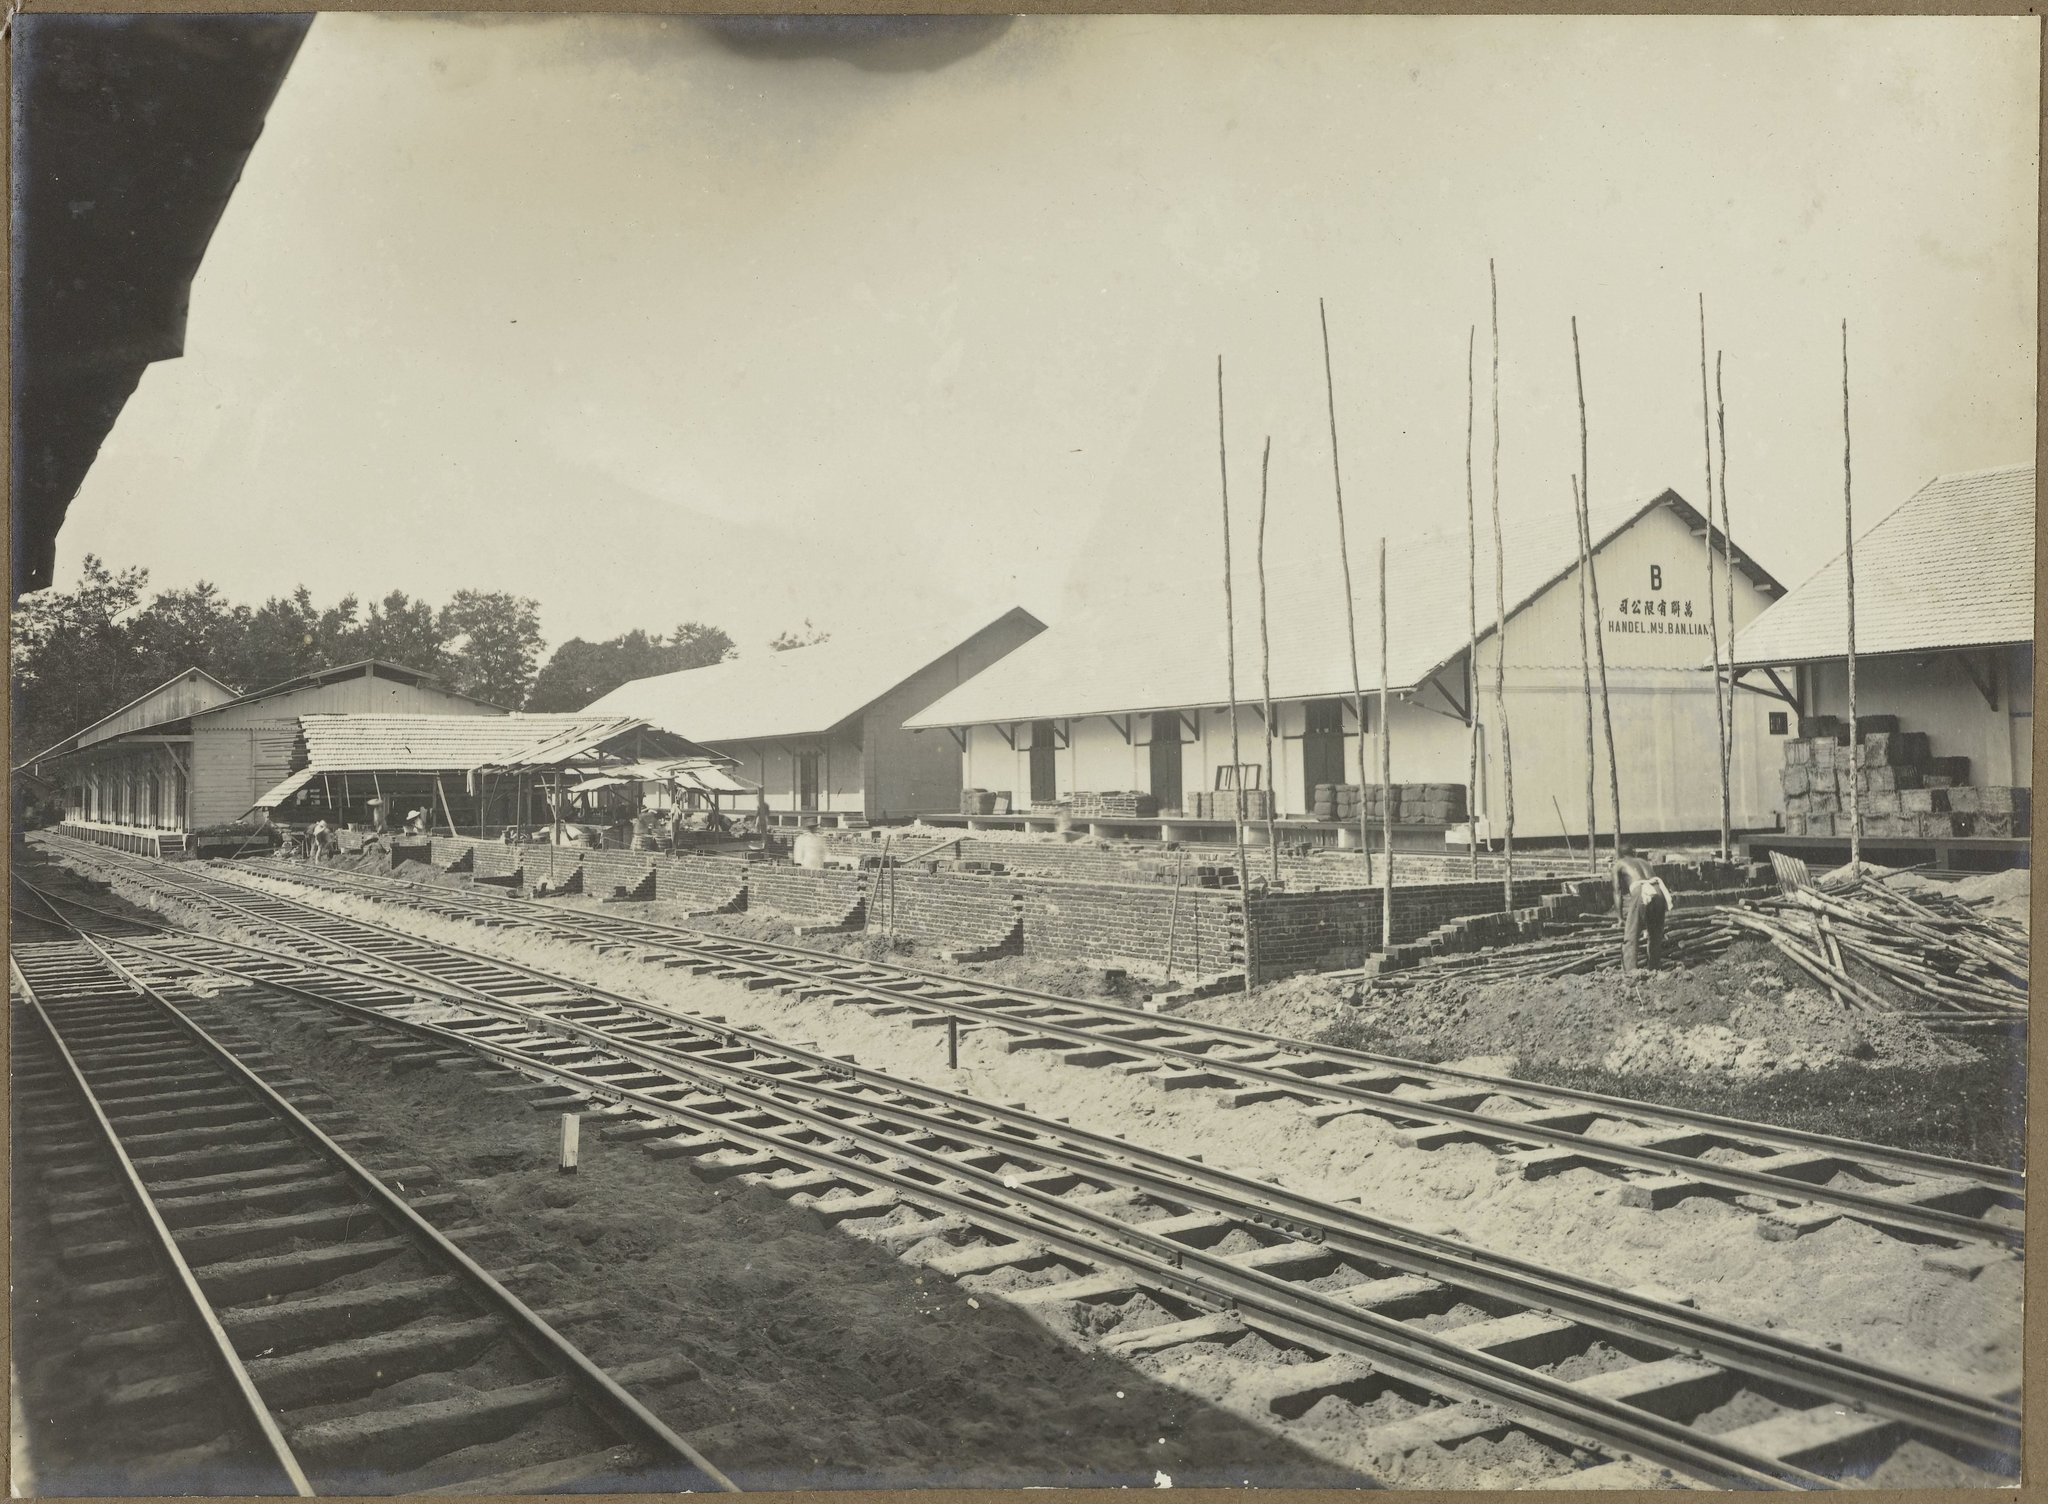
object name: photograph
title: Bouw van een pand langs het spoor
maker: Anonymous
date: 1914-1919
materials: photographic support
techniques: gelatin silver print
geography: medan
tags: making the overground structures (~ building activities), railway, train, representation of real building (either existing or having existed), architecture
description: De bouw van een bedrijfspand langs aan het spoor, waarschijnlijk te Medan. Foto in het fotoalbum van het Nederlandse architectenbureau en aannemersbedrijf Bennink en Riphagen te Medan in de jaren ca. 1914-1919.